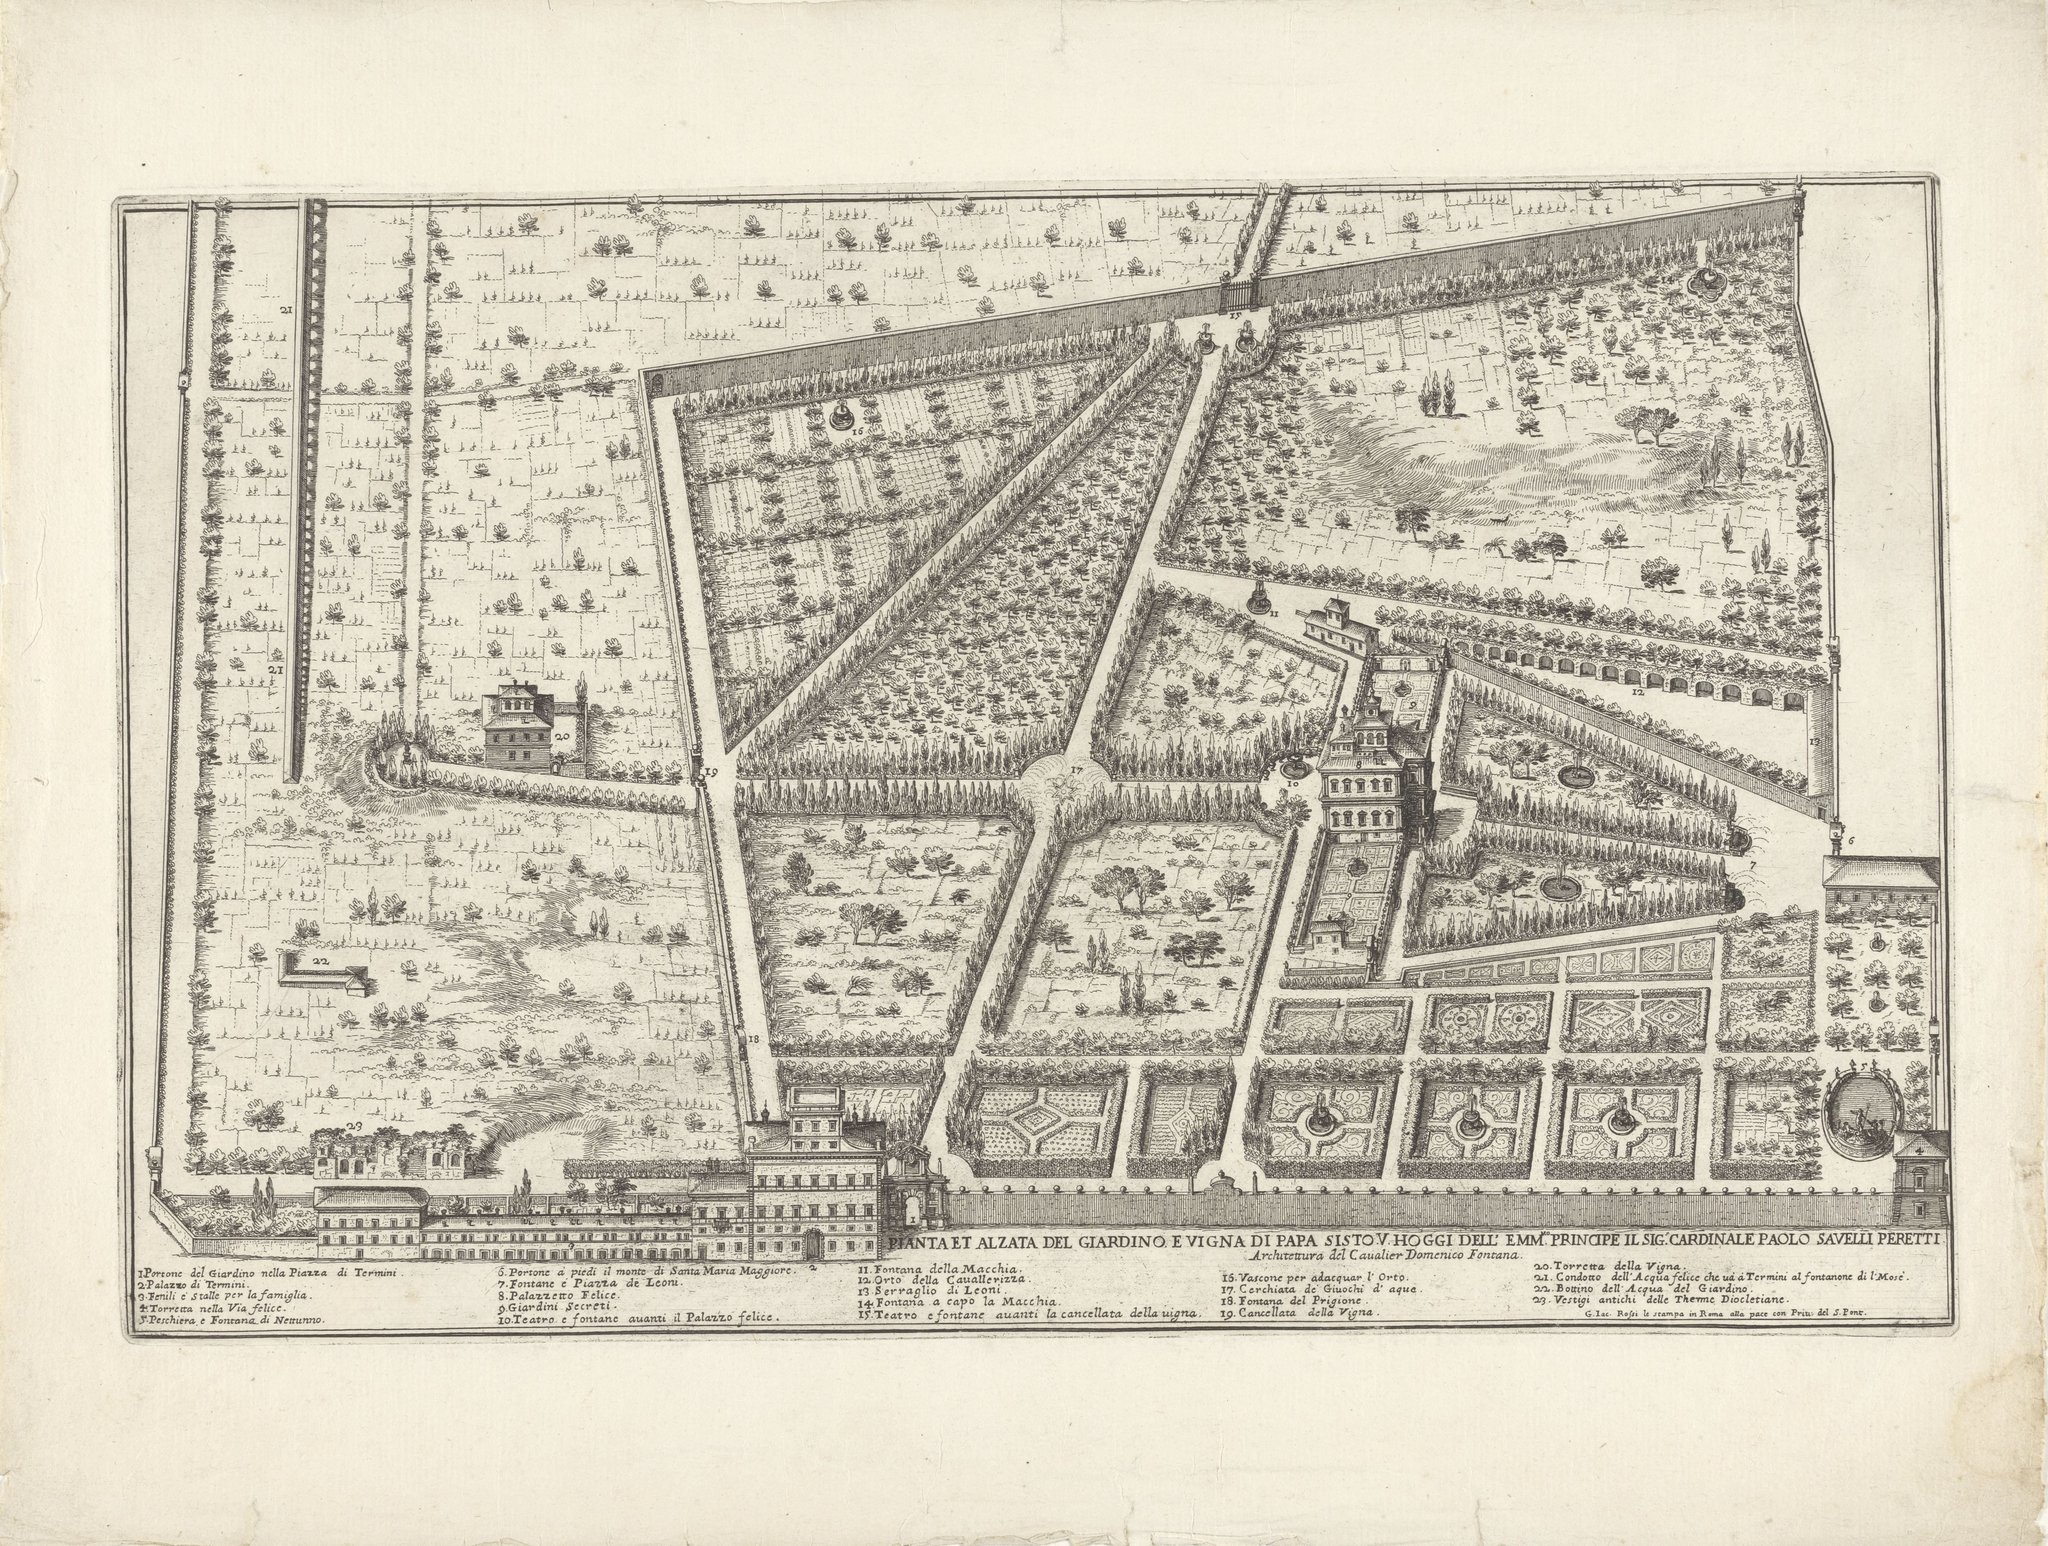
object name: print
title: Li giardini di Roma / con le loro piante alzate / e vedute in prospettiva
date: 1683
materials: paper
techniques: etching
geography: vatican city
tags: switzerland, naples, domenico fontana, vineyard, garden, italy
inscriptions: collector's mark: Lugt 2228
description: Plattegrond van de tuin en wijngaard van paus Sixtus V en de tuin van kardinaal Paolo Savelli. In de ondermarge de titel en een verklarende lijst met nummers.